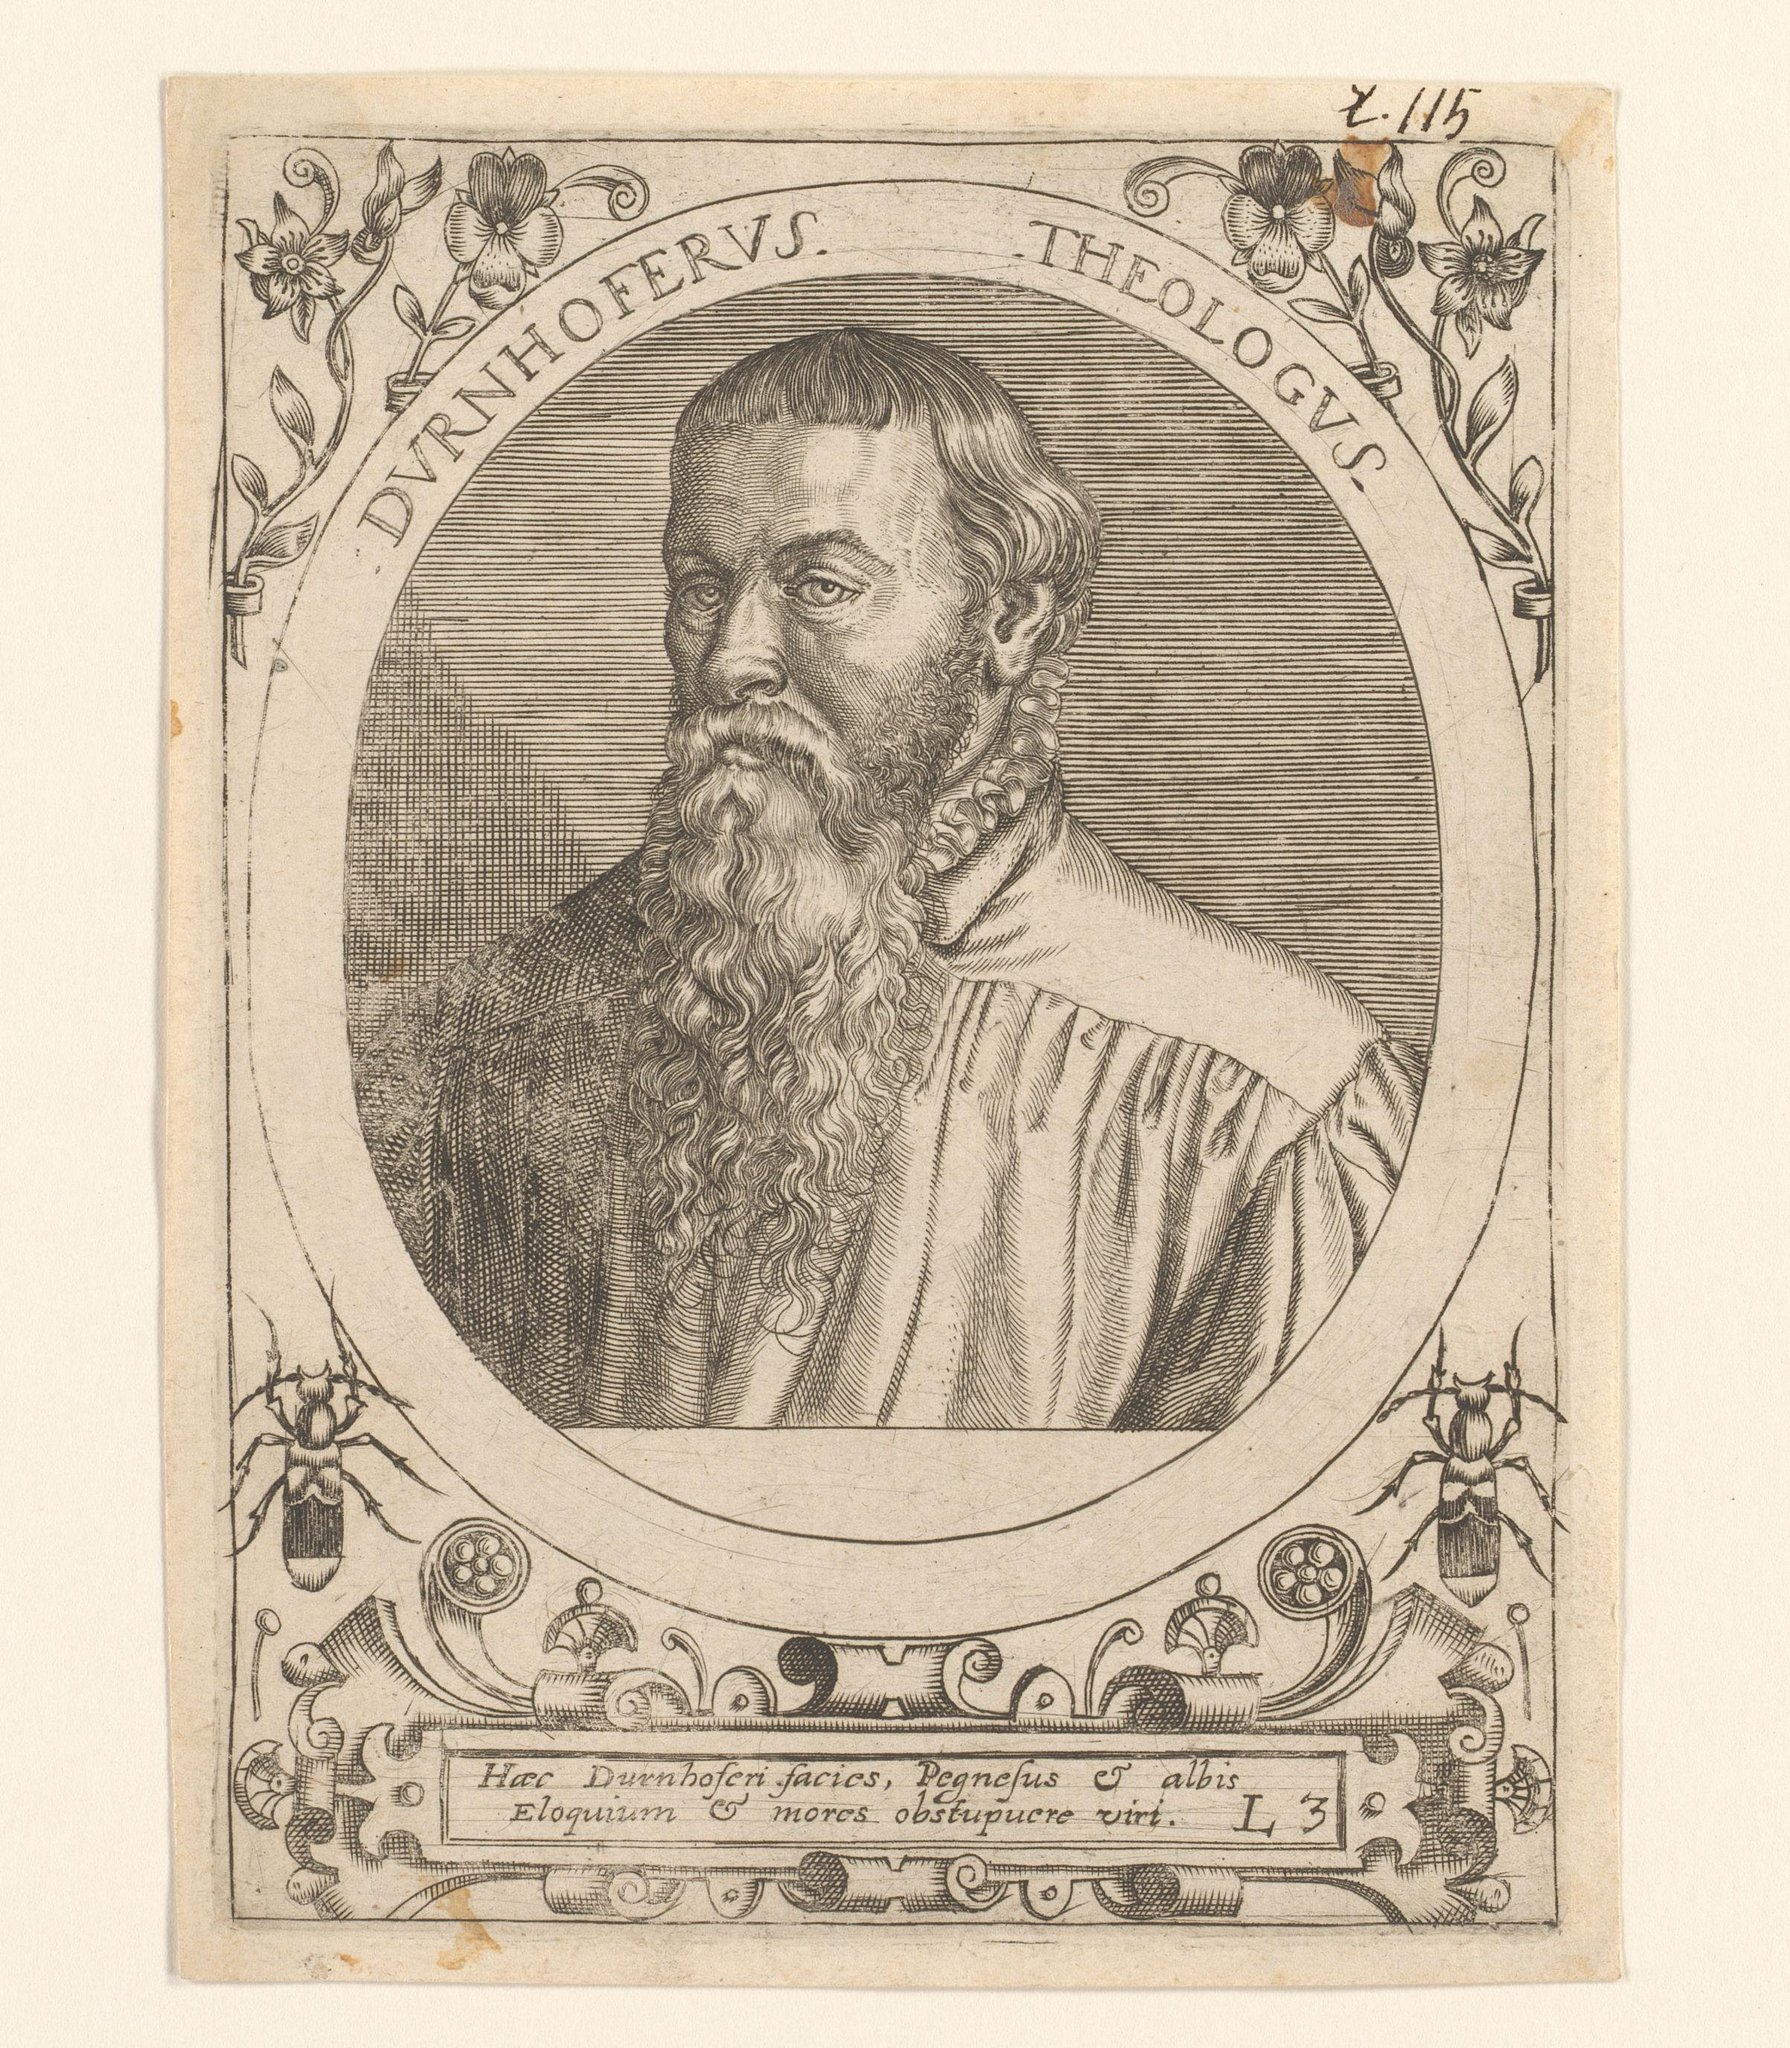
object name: book illustration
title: Portret van Lorenz Dürnhofer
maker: jean jacques boissard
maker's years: 1528-1598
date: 1650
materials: paper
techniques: engraving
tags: theologian, historical persons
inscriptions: inscription: ‘L. 115’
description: Prent gebruikt in: Boissard, Jean Jacques. Bibliotheca chalcographica. 8 dln. Frankfurt am Main: Johannes Ammon, 1650-1652. Ook gebruikt in latere edities. Eerdere staat van prent verschenen in: Boissard, Jean Jacques. Icones quinquaginta virorum illustrium doctrina & eruditione praestantium ad vivum effictae. 4 dln. Frankfurt am Main: s.n., 1597-1599. Mogelijk ook gebruikt in latere edities.